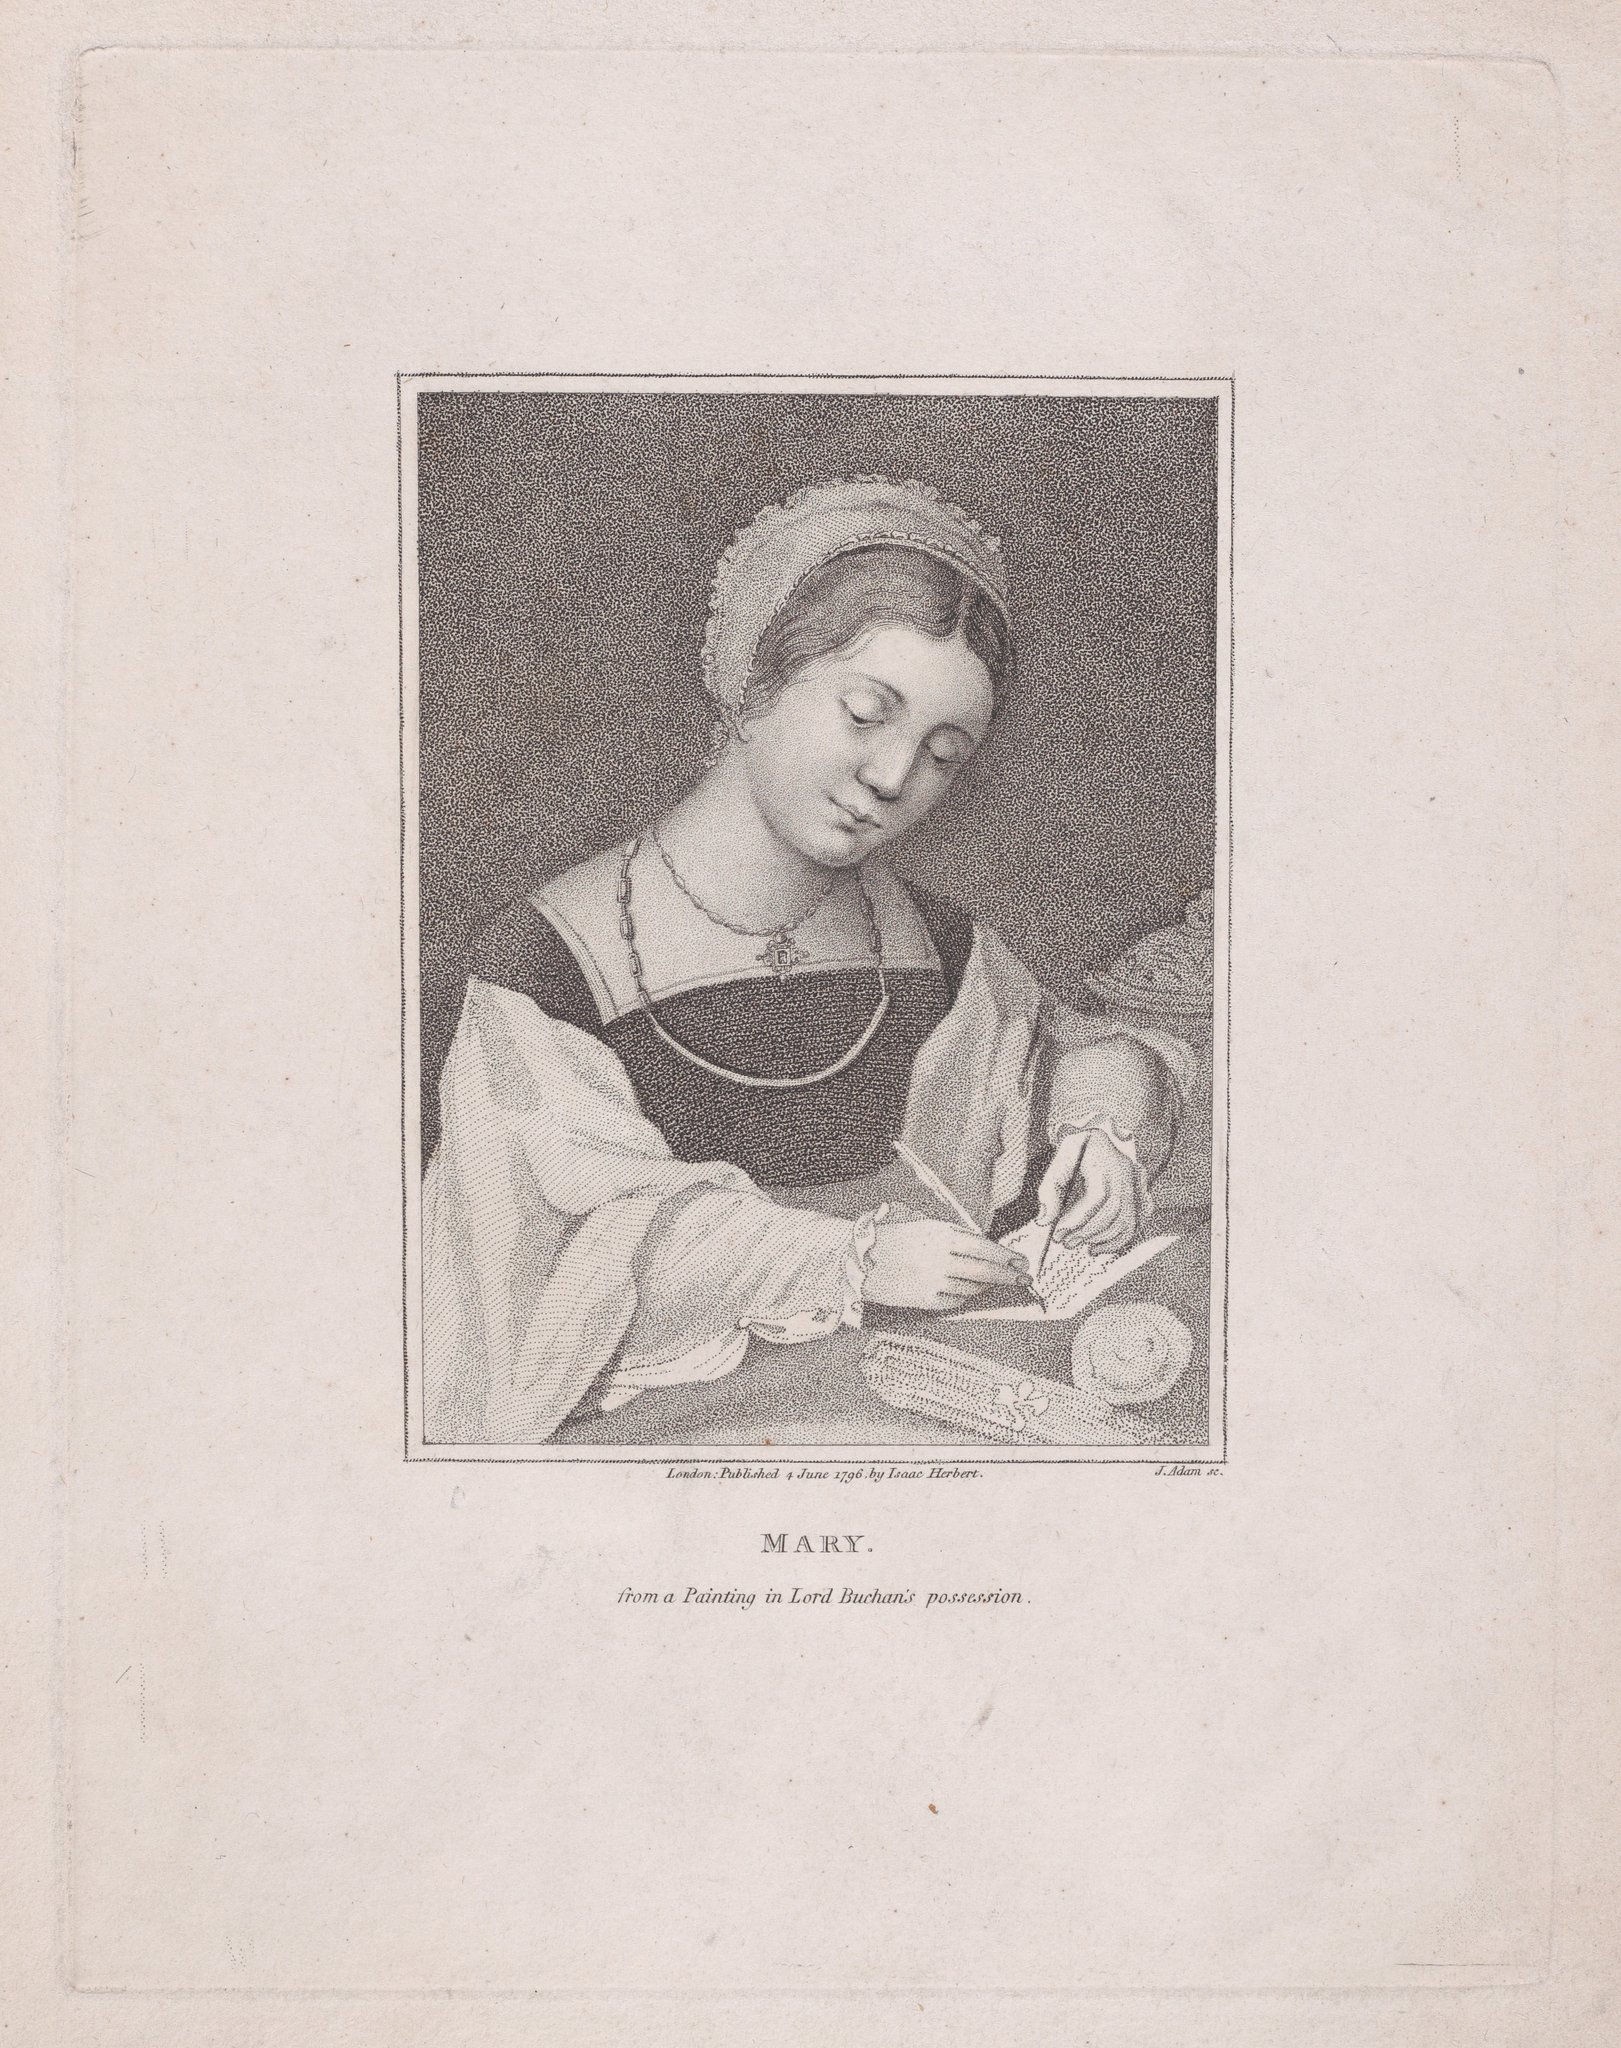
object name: print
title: Mary, Queen of Scots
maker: isaac herbert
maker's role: publisher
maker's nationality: british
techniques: engraving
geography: england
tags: queens,women,writing,mary queen of scots